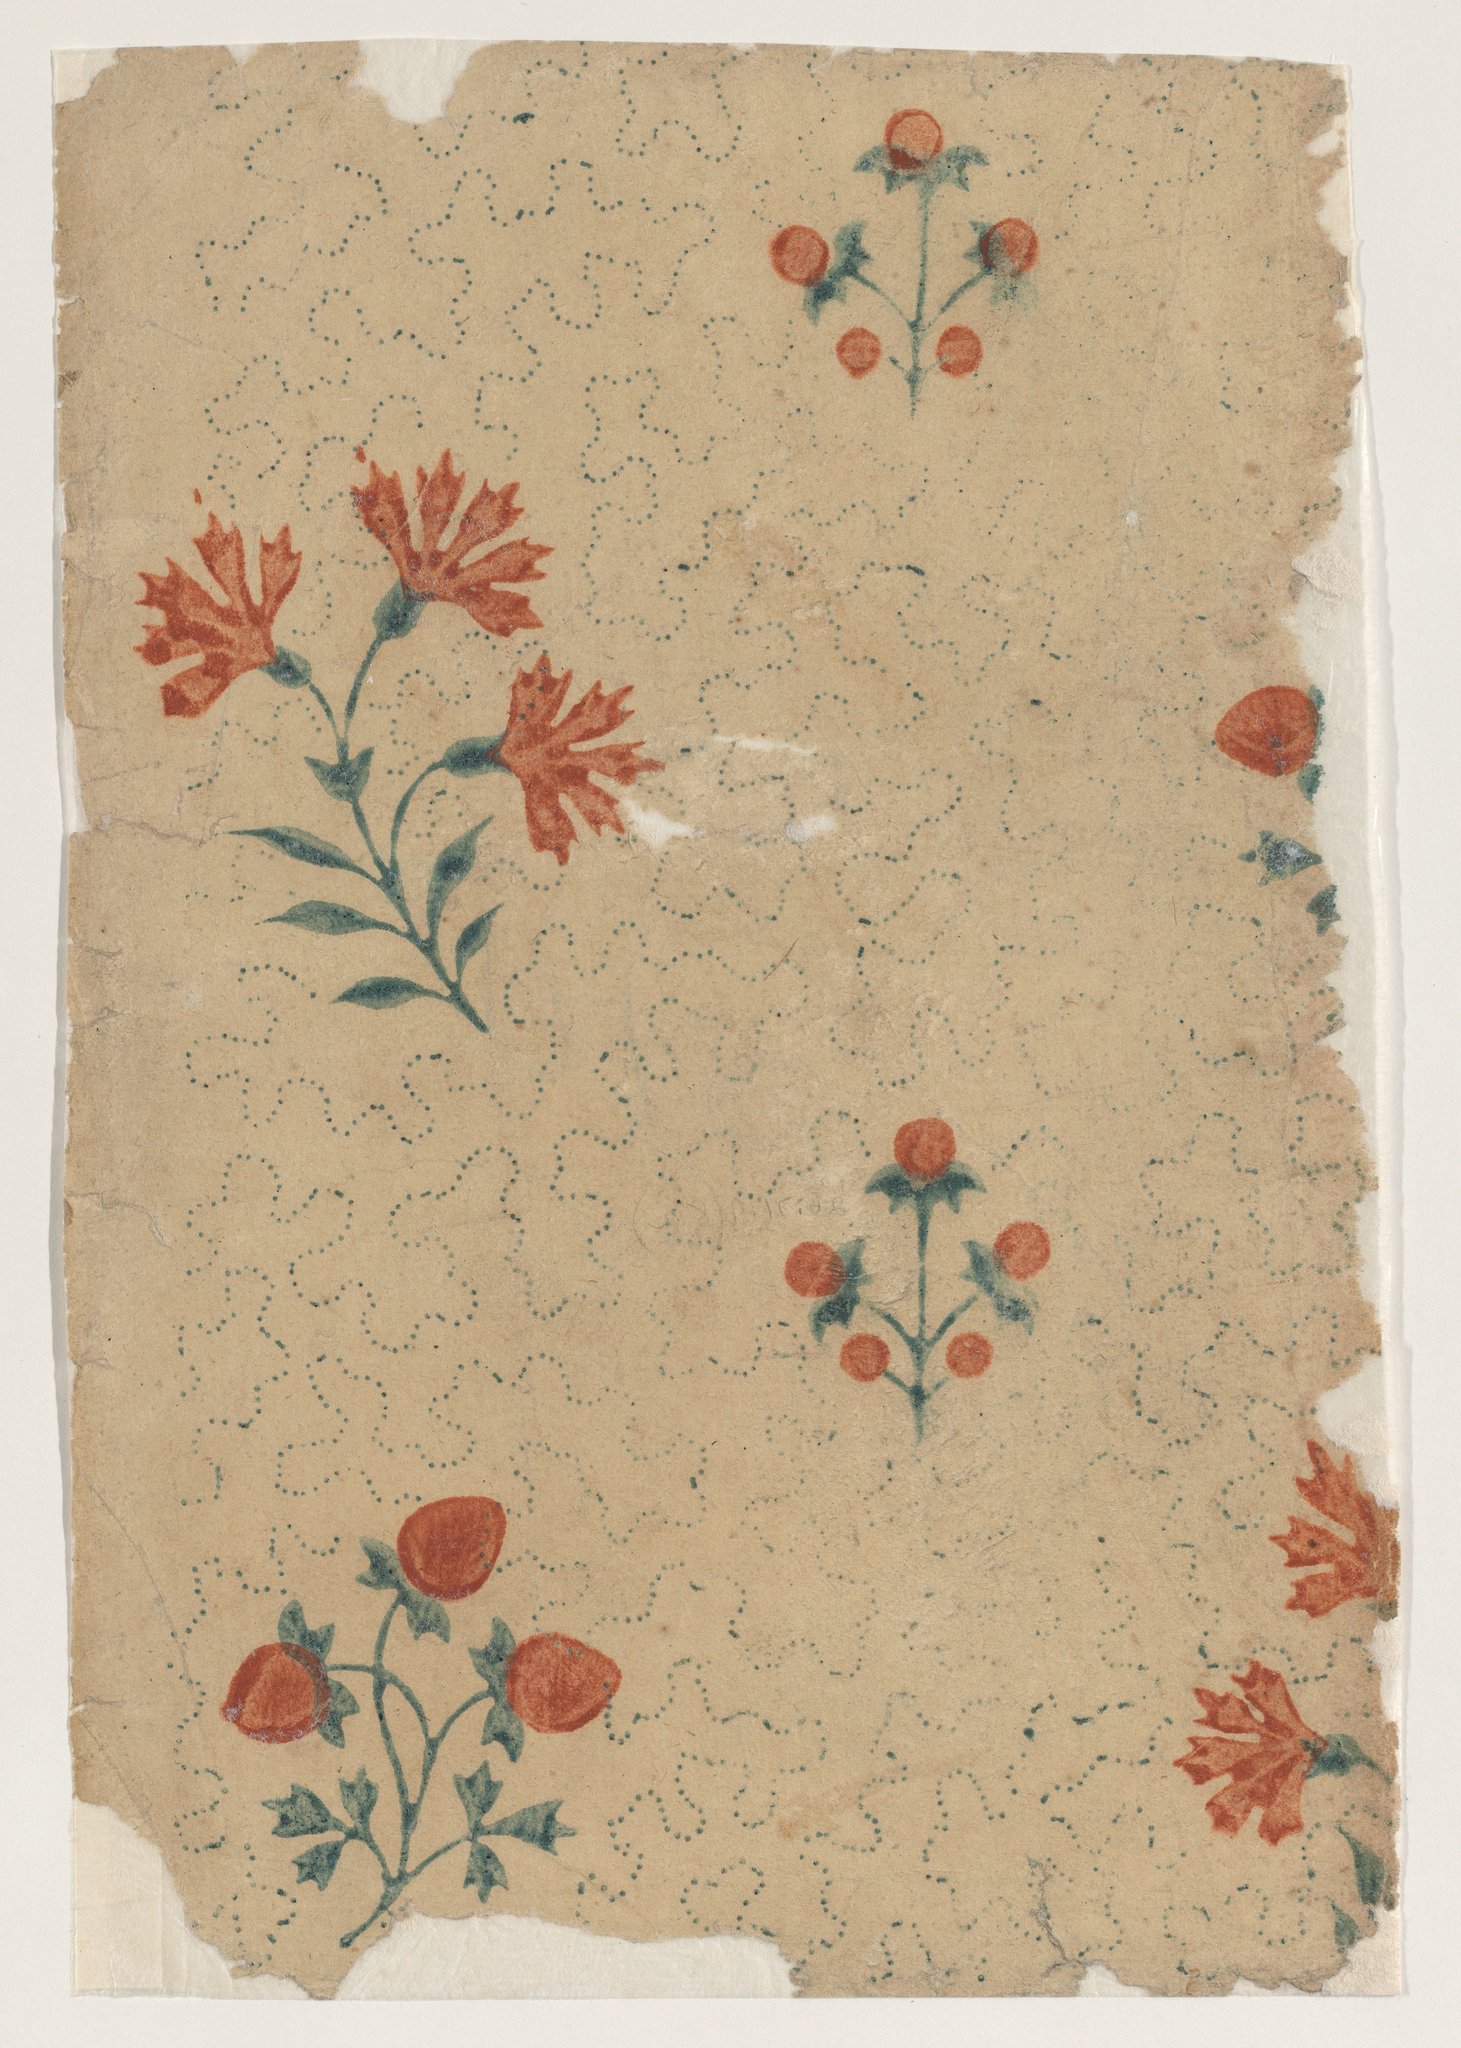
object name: print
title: Sheet with overall dot pattern with bouquets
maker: Anonymous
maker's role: artist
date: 1801-1900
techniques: relief print